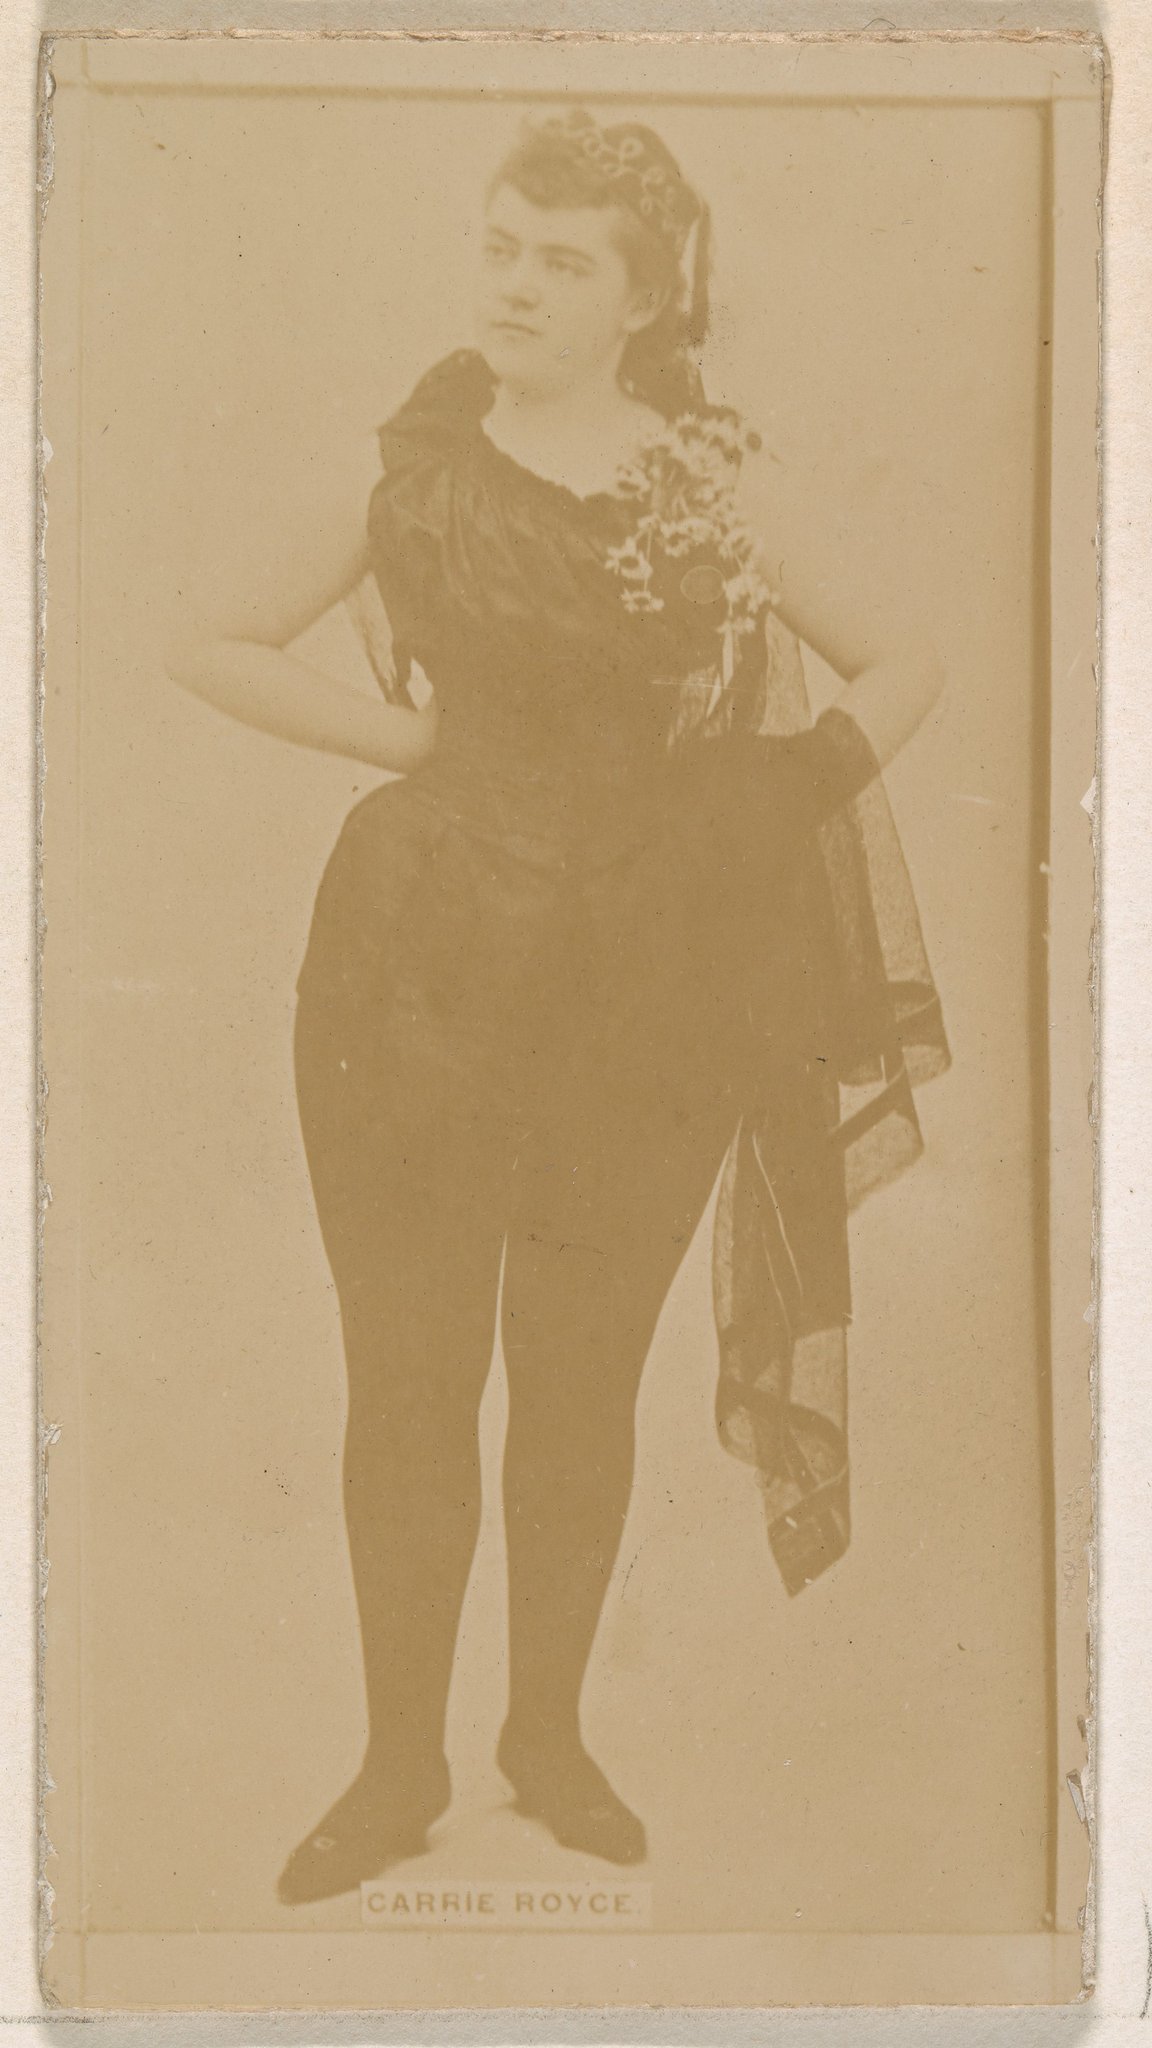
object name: photograph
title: Carrie Royce, from the Actresses series (N245) issued by Kinney Brothers to promote Sweet Caporal Cigarettes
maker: kinney brothers tobacco company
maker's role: publisher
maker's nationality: american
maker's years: 1869-2011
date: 1890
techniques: albumen silver print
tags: portraits,women,actresses